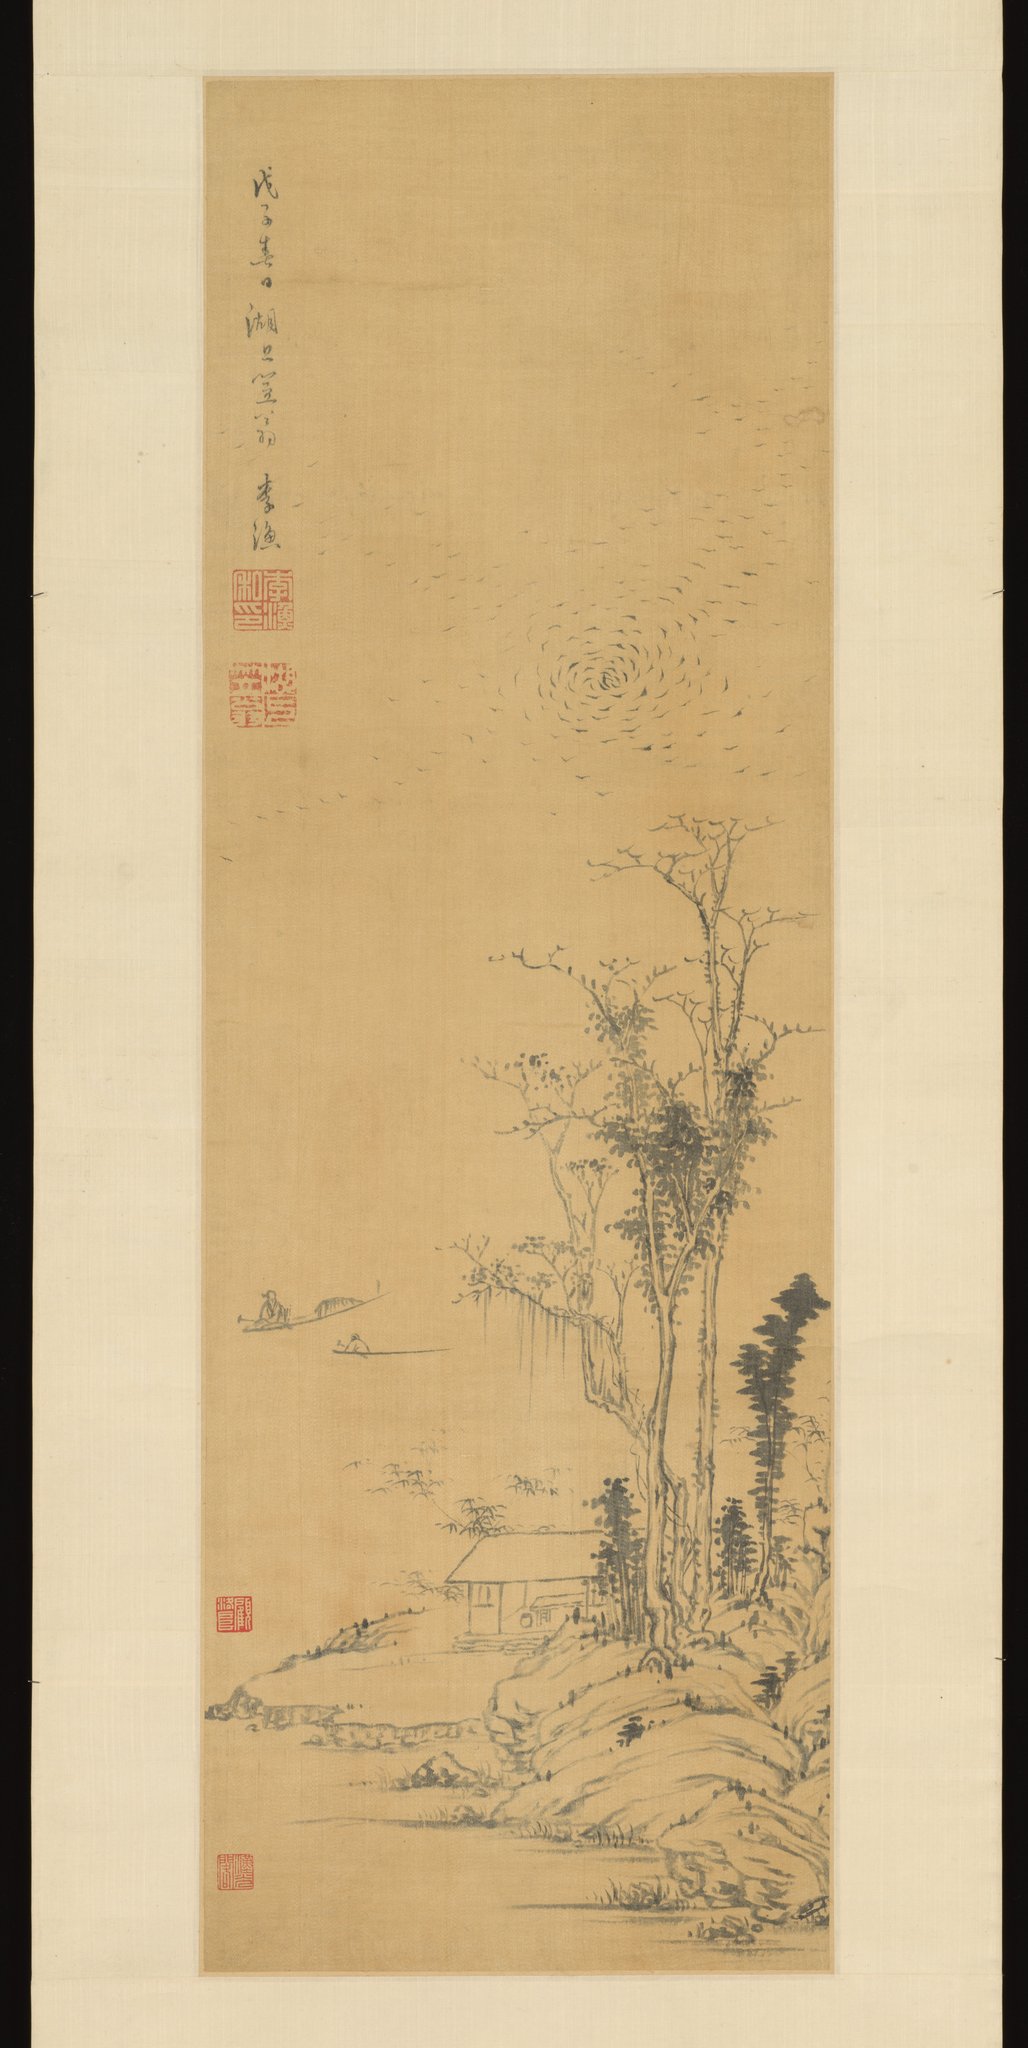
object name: hanging scroll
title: Landscape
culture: chinese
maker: li yu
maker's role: artist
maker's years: 1611-1680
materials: ink, textile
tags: landscapes,boats